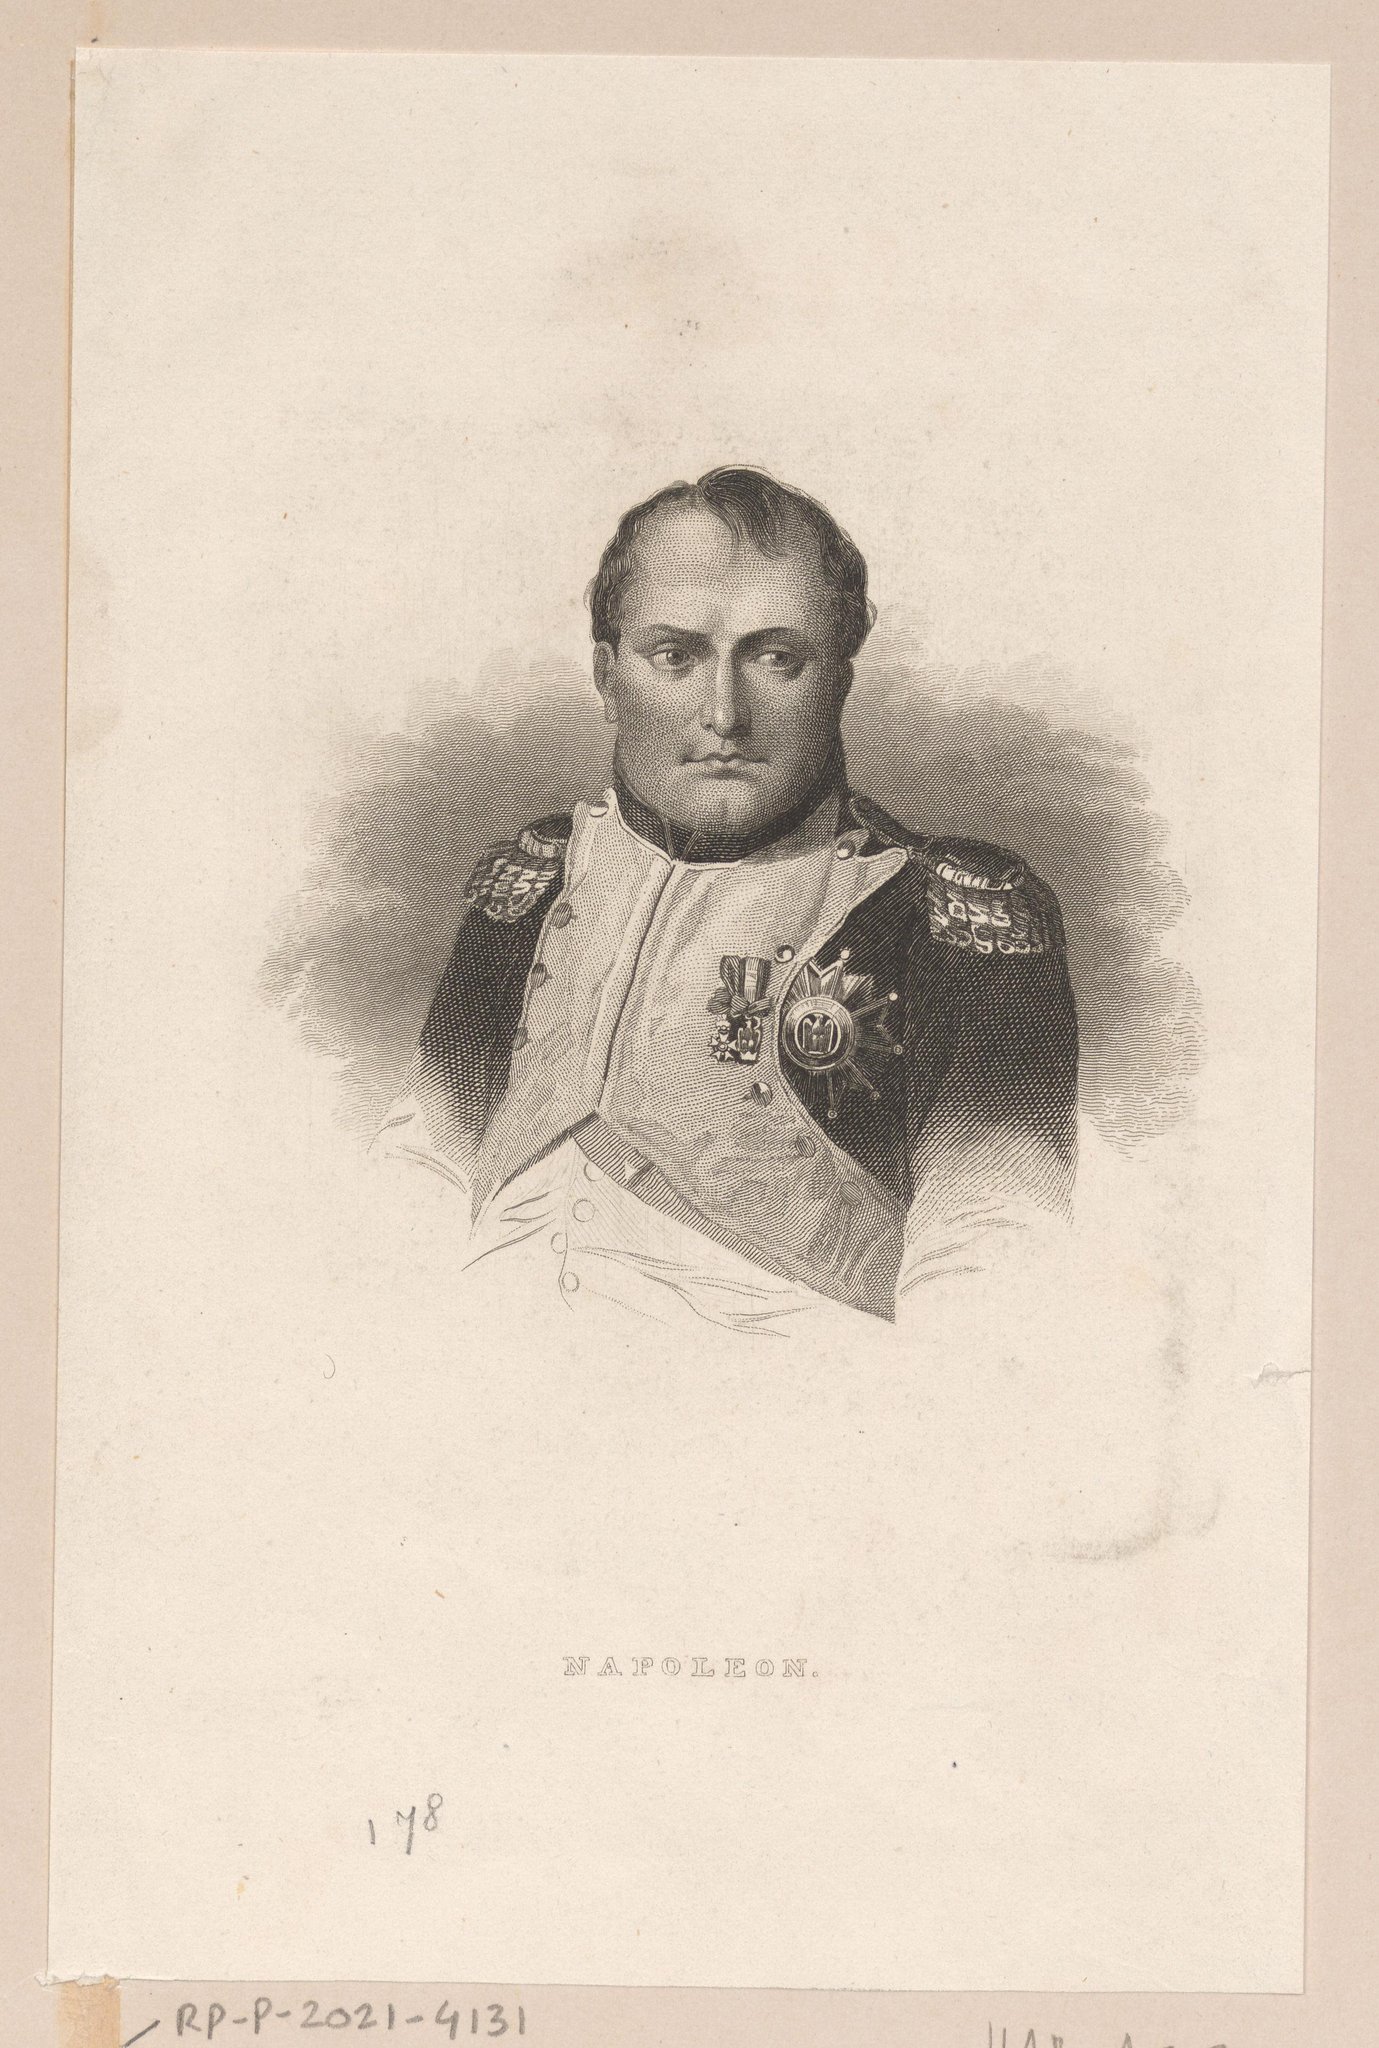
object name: print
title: Portret van Napoleon I Bonaparte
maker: Anonymous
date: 1841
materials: paper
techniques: engraving, etching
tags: napoleon i (emperor of the french), historical persons, emperor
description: Prent mogelijk uit: Sporschil, Johann. Die große Chronik: Geschichte des Krieges des verbündeten Europa's gegen Napoleon Bonaparte (...) Braunschweig: George Westermann, 1841, dl. 2. Of uit: Berge, Adalbert vom. Napoleons Leben. Berlin: C.F. Kecht, 1841, dl. 1.